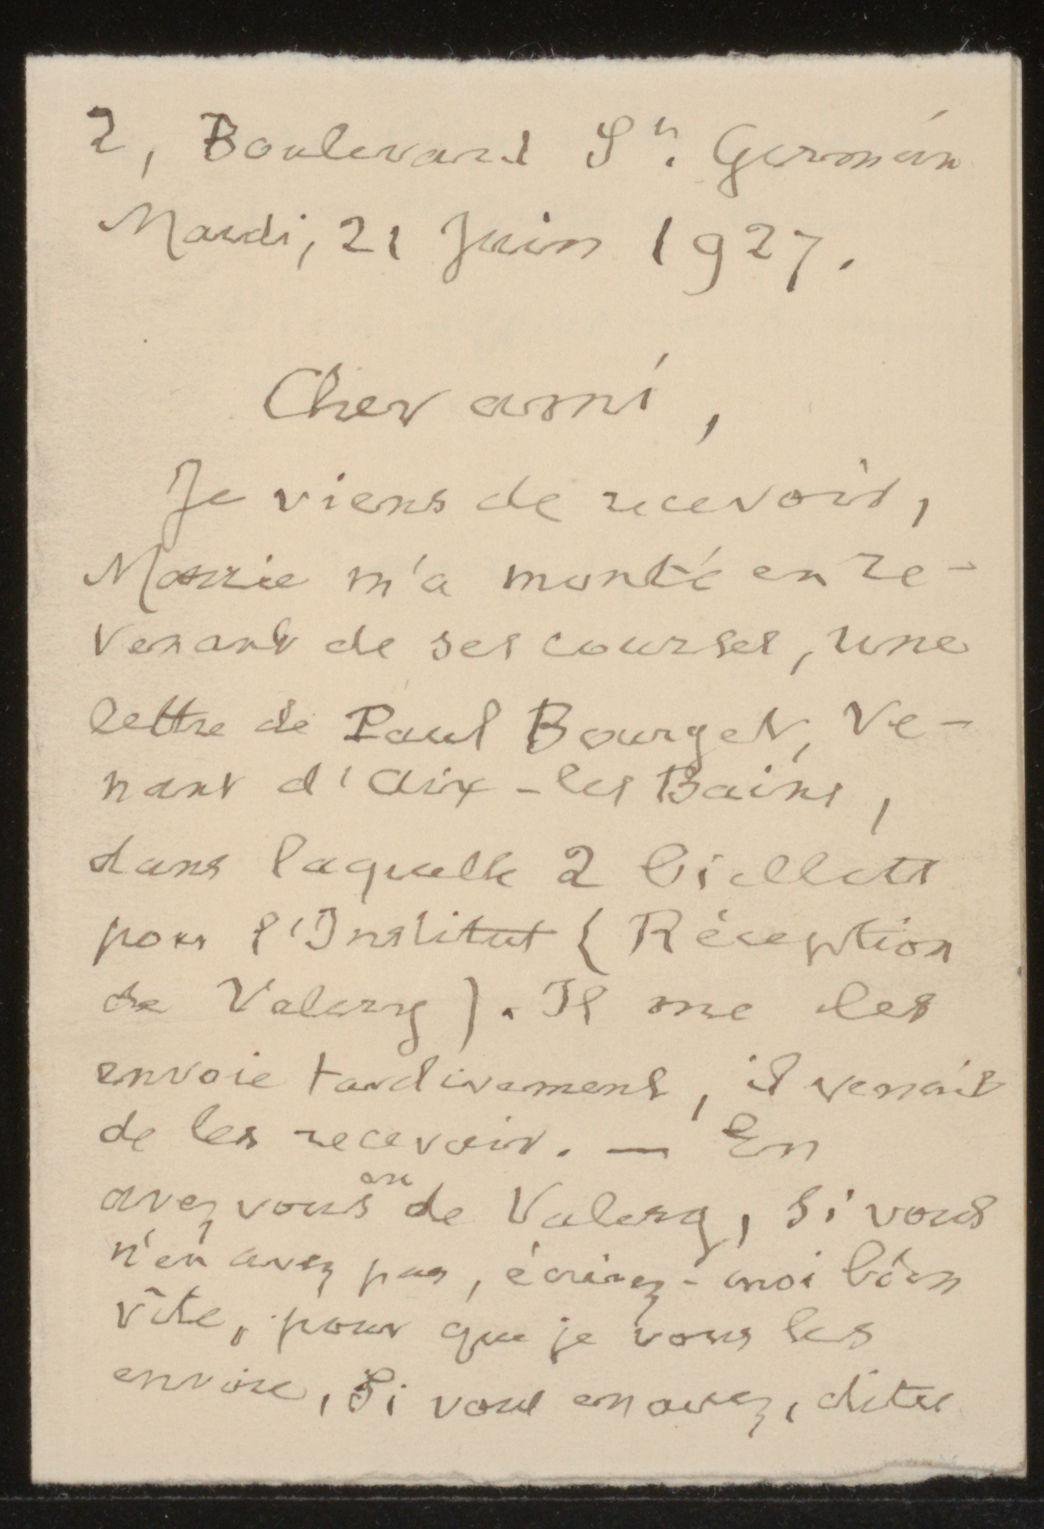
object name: letter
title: Brief aan Louis Leleu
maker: louise read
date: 1927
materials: ink, paper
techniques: pen, writing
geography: paris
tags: françoise w.m. bonger